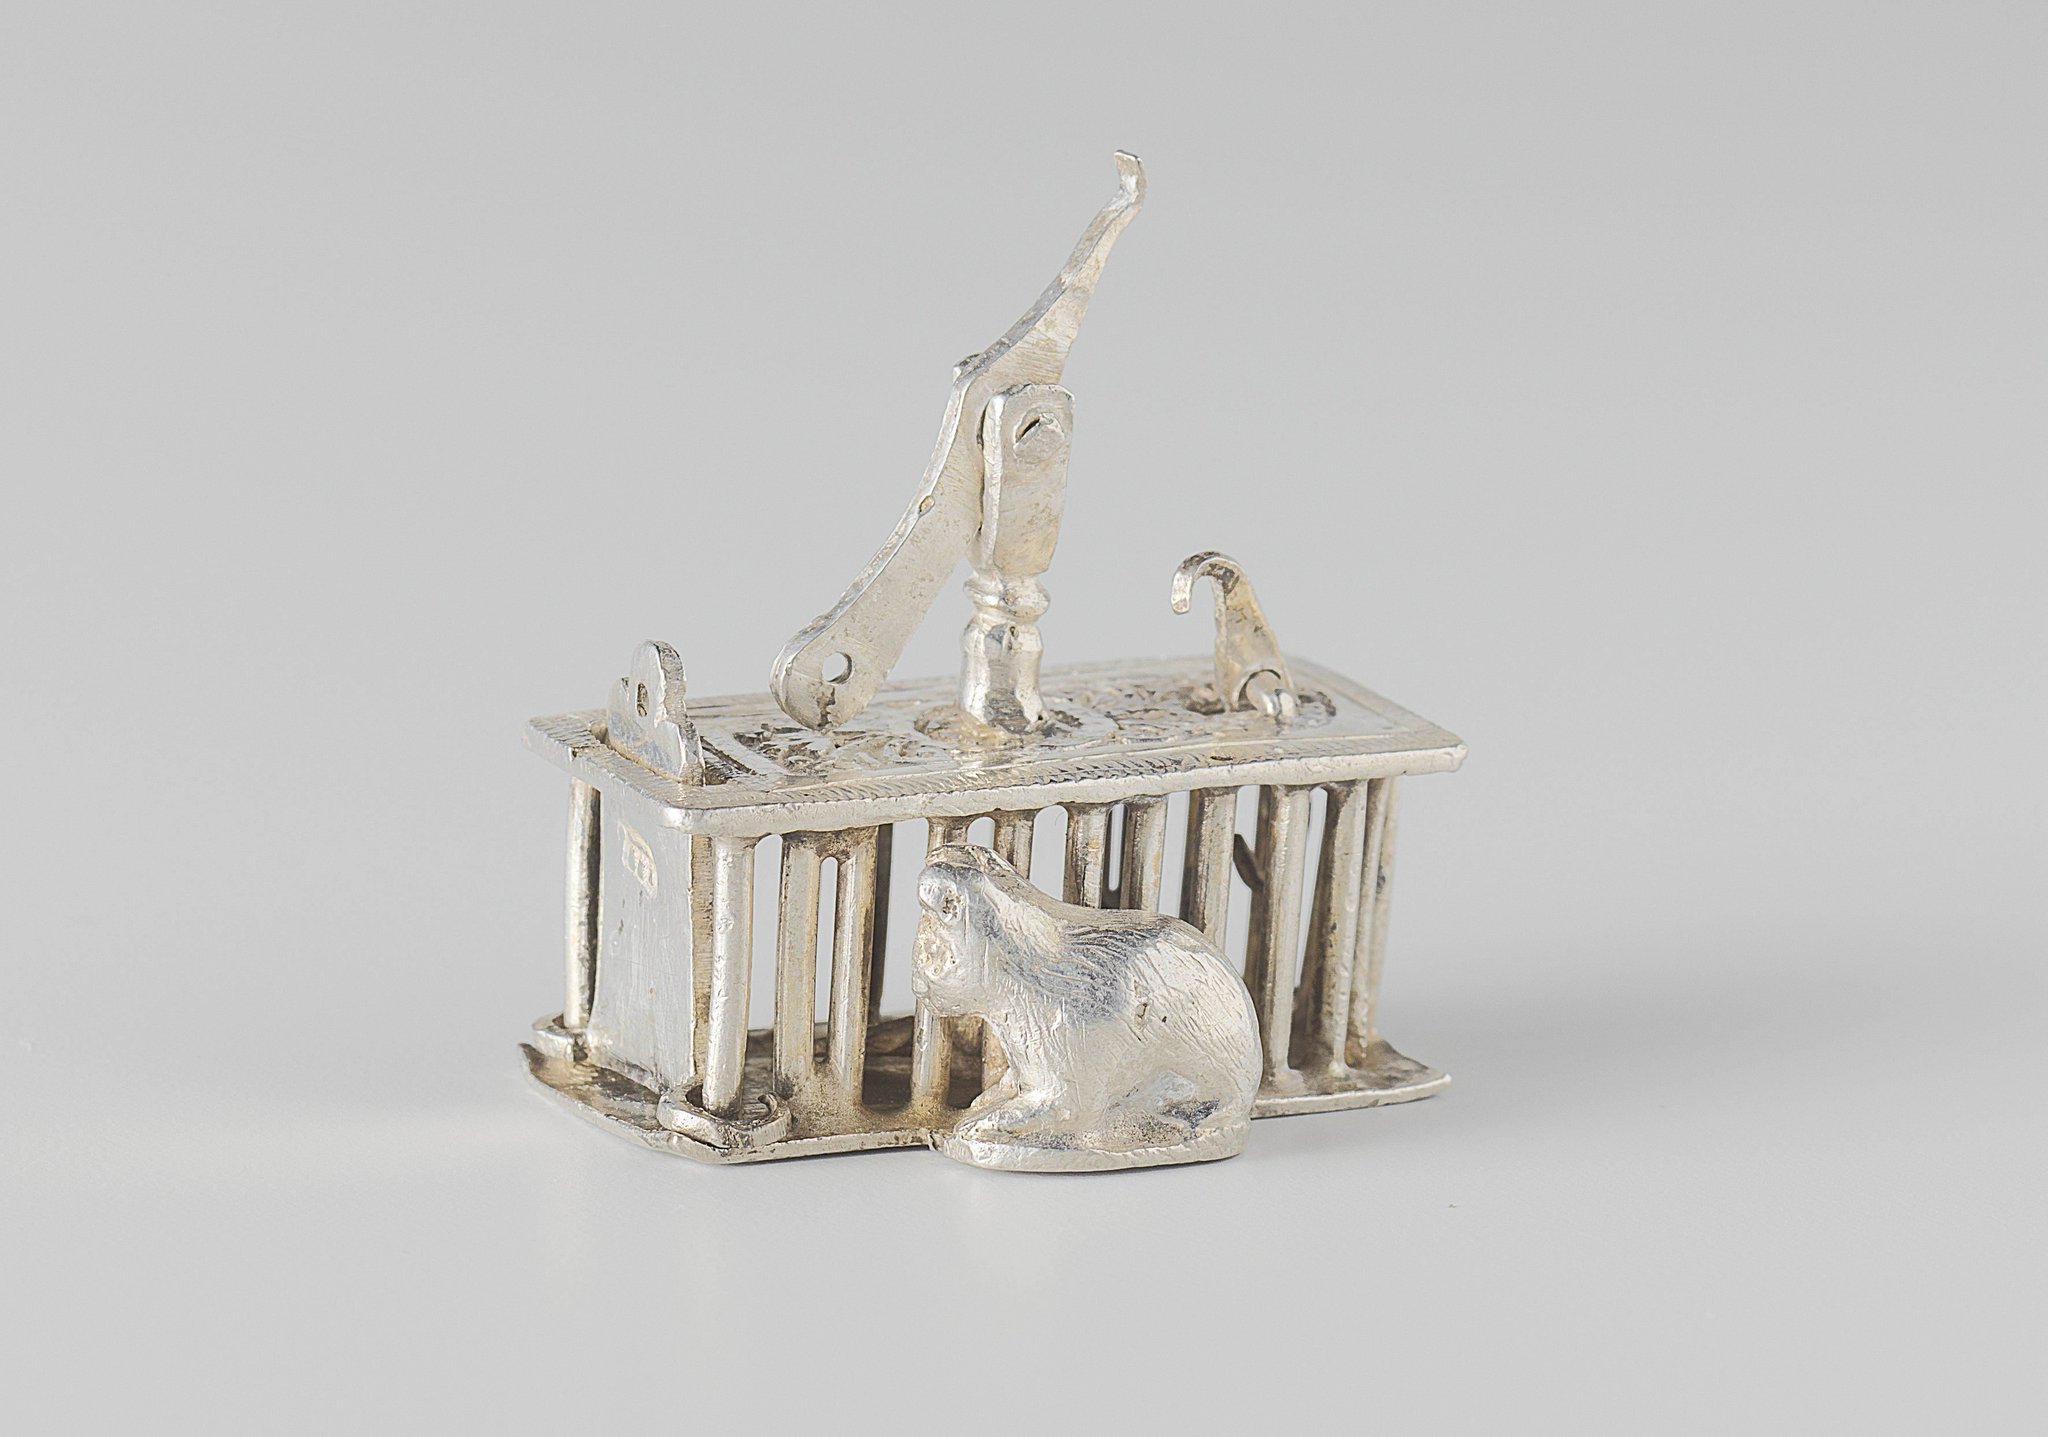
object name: miniature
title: Muizenval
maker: Anonymous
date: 1718-1734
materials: silver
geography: amsterdam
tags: mouse trap, cat and mouse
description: Langwerpige muizenval met beweegbaar valluik. De bovenkant is bewerkt en de zijkanten bestaan uit spijlen. In de val zit een muis en naast de val zit een poes. De muizenval is gemerkt: stk.= Amsterdam en een bijltje.